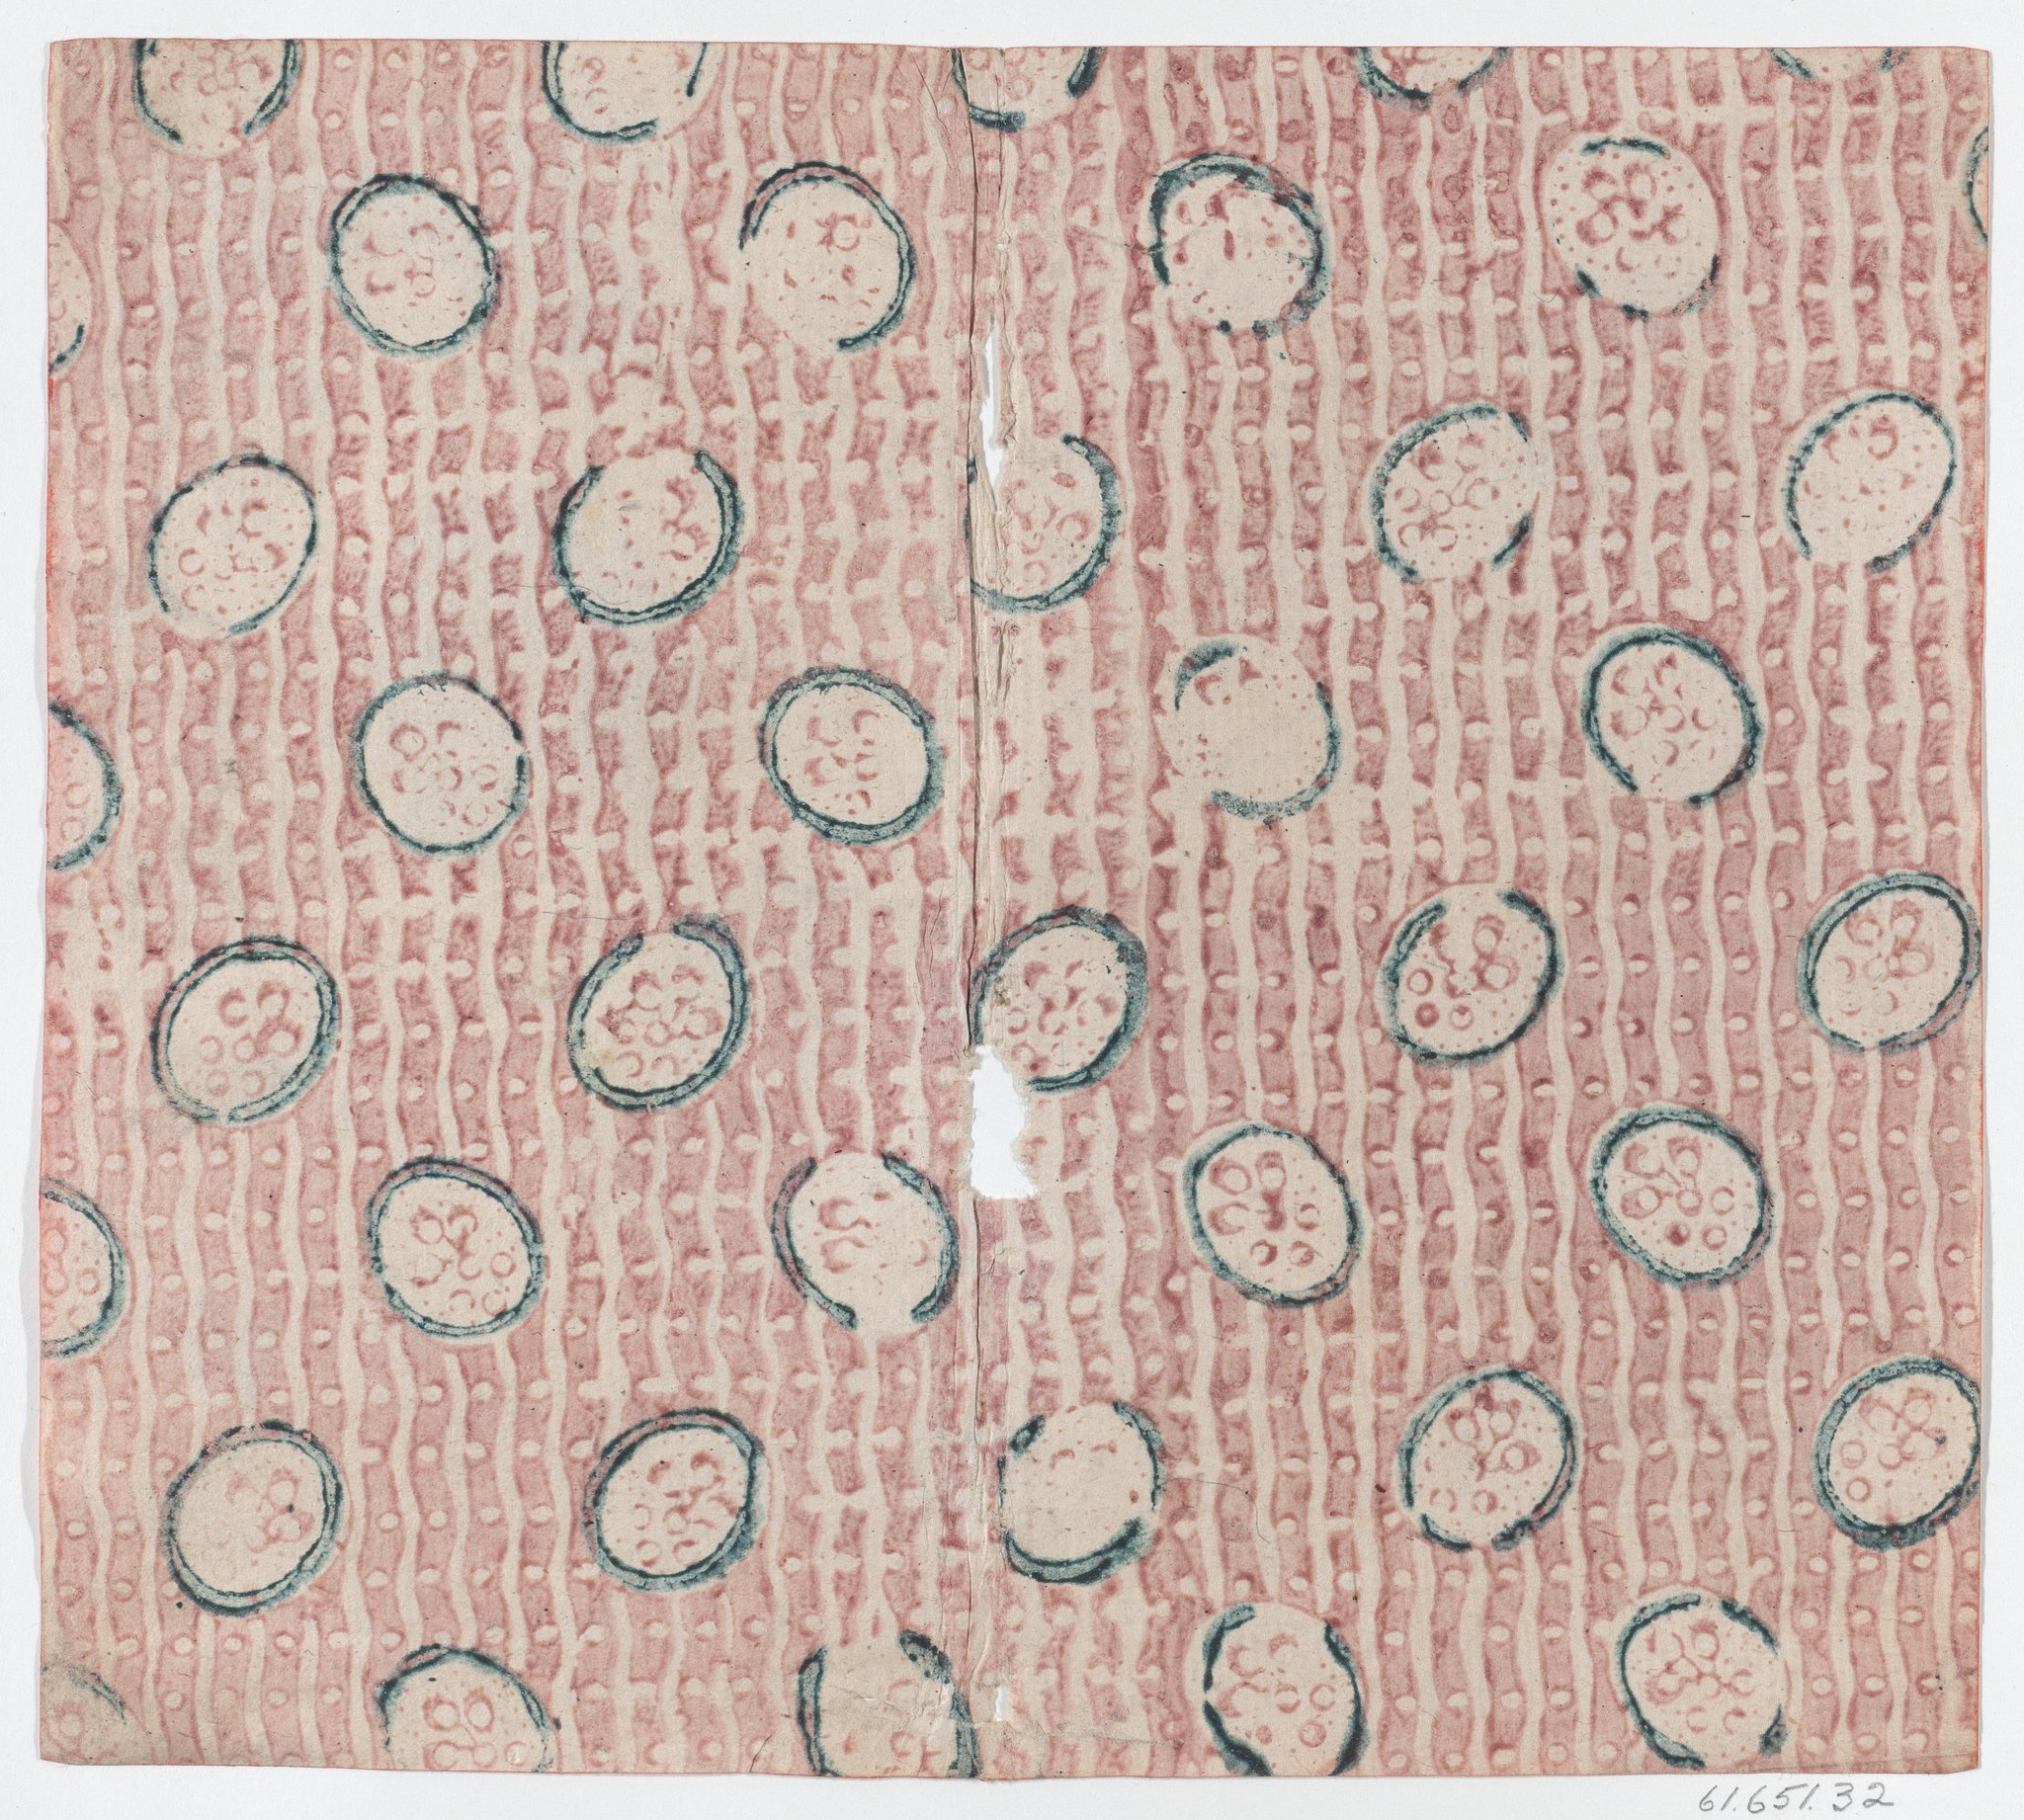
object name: print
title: Sheet with curved line and oval pattern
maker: Anonymous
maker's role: artist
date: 1701-1800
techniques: relief print